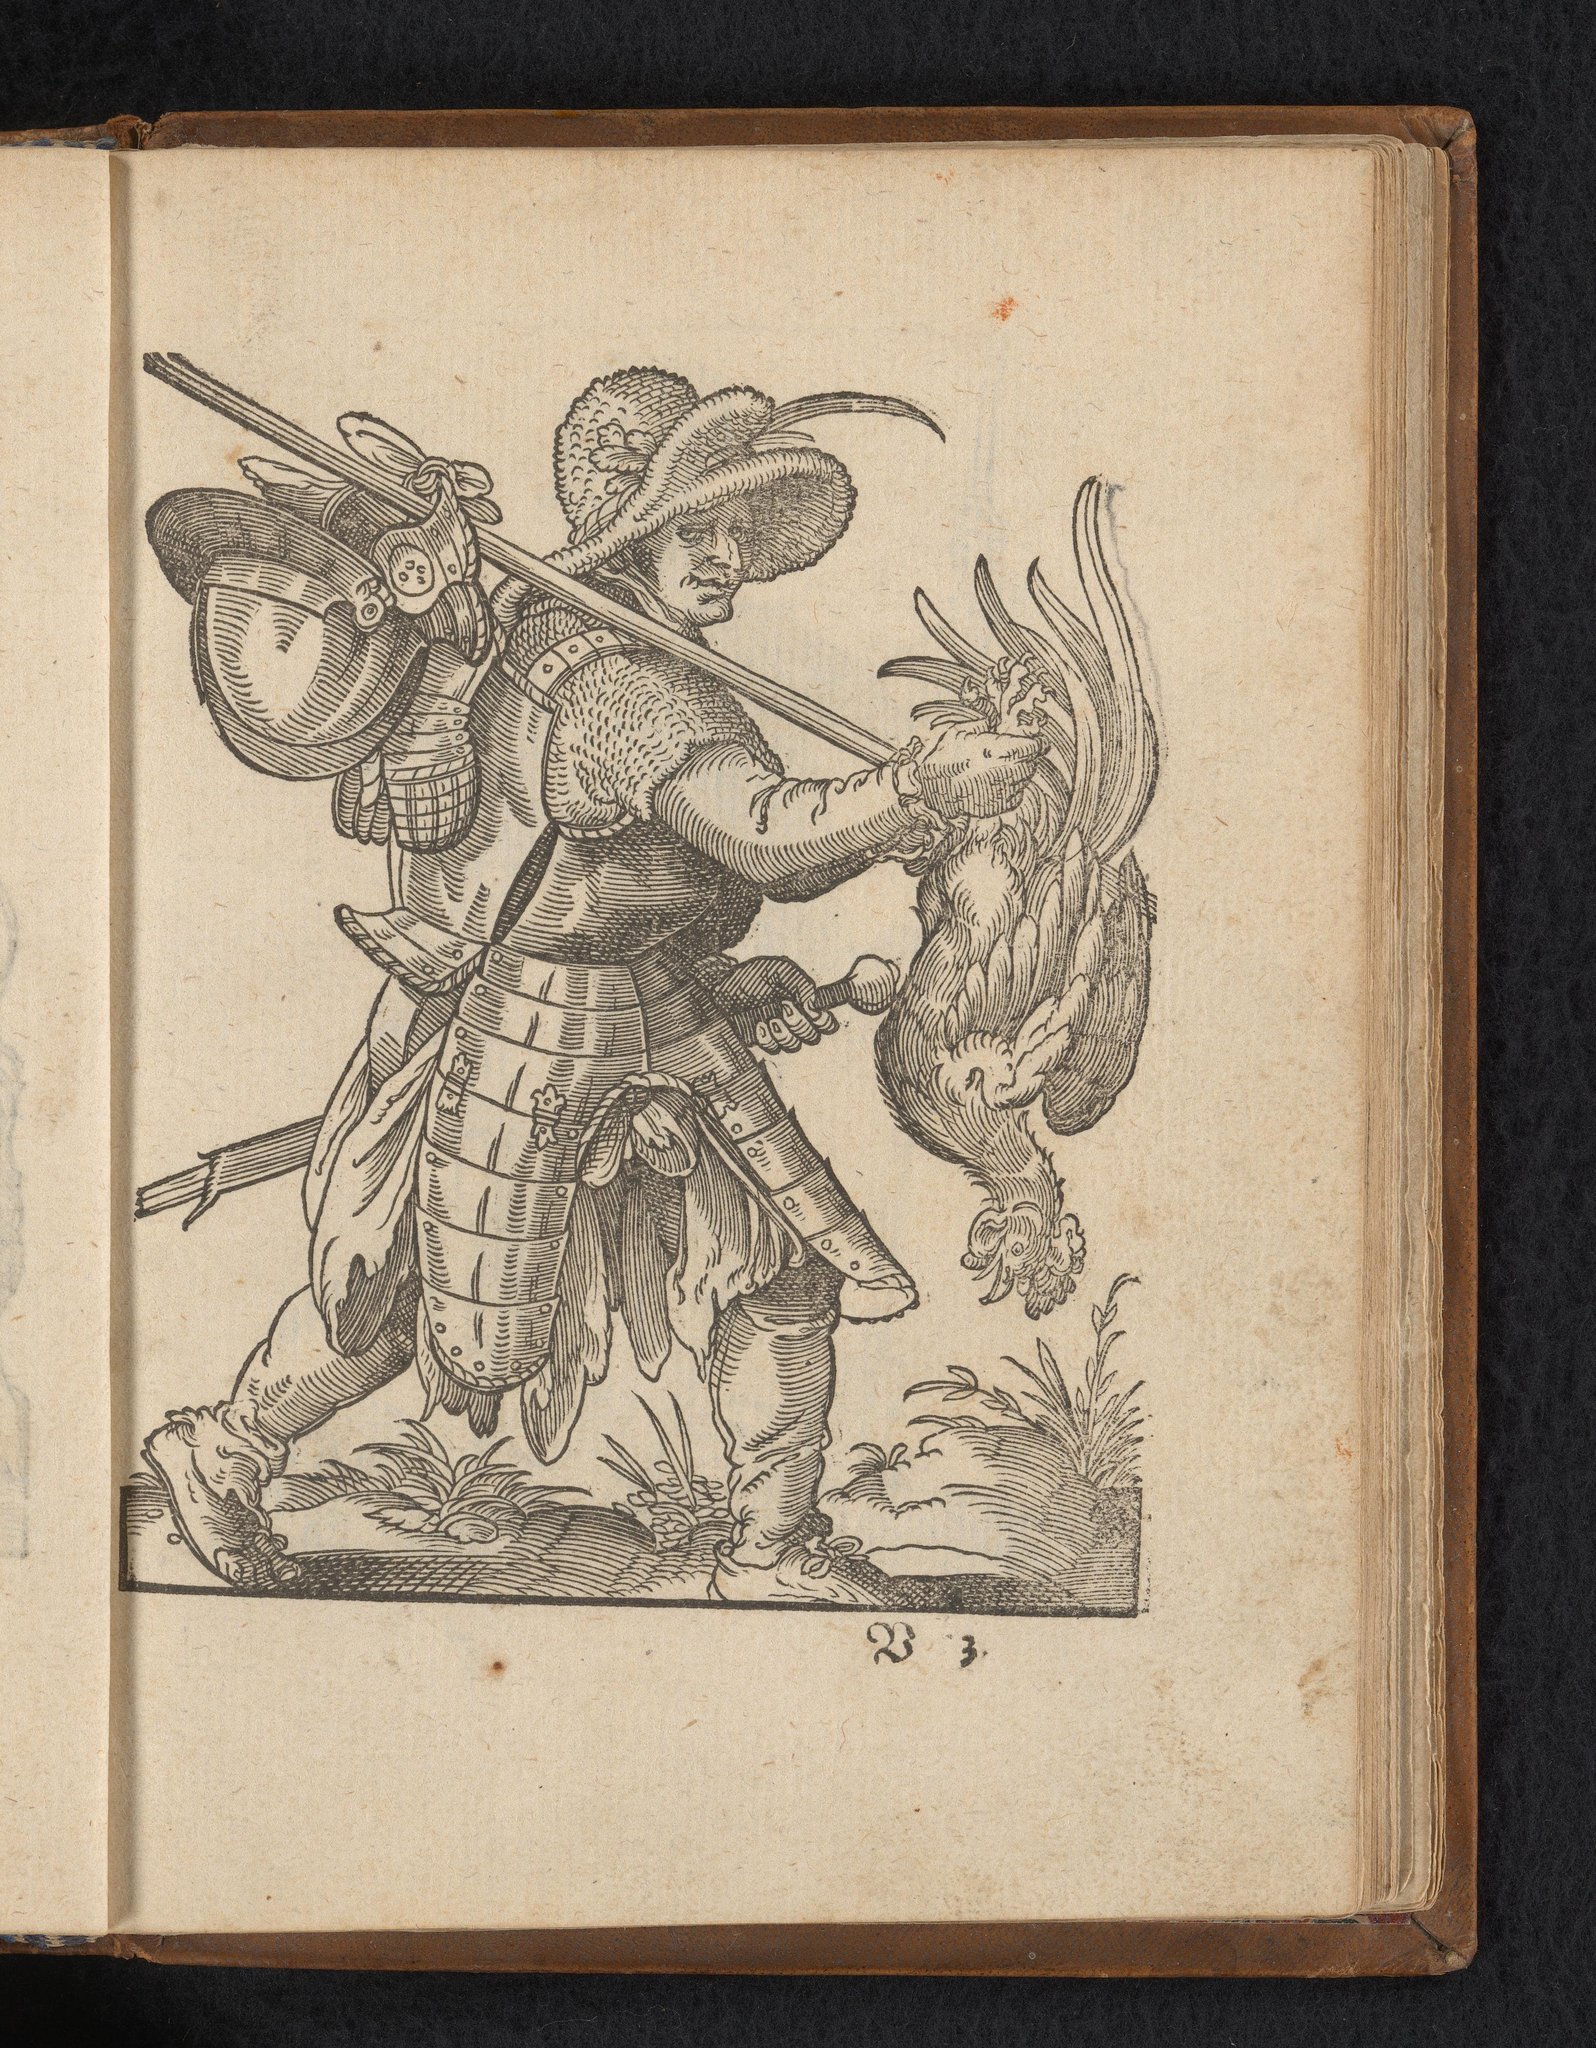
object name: print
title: Lansknecht met kip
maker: Anonymous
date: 1578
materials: paper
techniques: woodcut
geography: nuremberg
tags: land forces, fowl (cock, hen, chicken, etc.)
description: Een lansknecht die zijn helm en een deel van zijn harnas heeft uitgetrokken, op zijn hoofd een hoed met een veer en hij draagt in zijn handen een kip. Onderdeel van het modelboek Enchiridion artis pingendi, fingendi & sculpendi met 108 figuren bedoeld voor beginnende schilders, beeldhouwers en prentmakers.